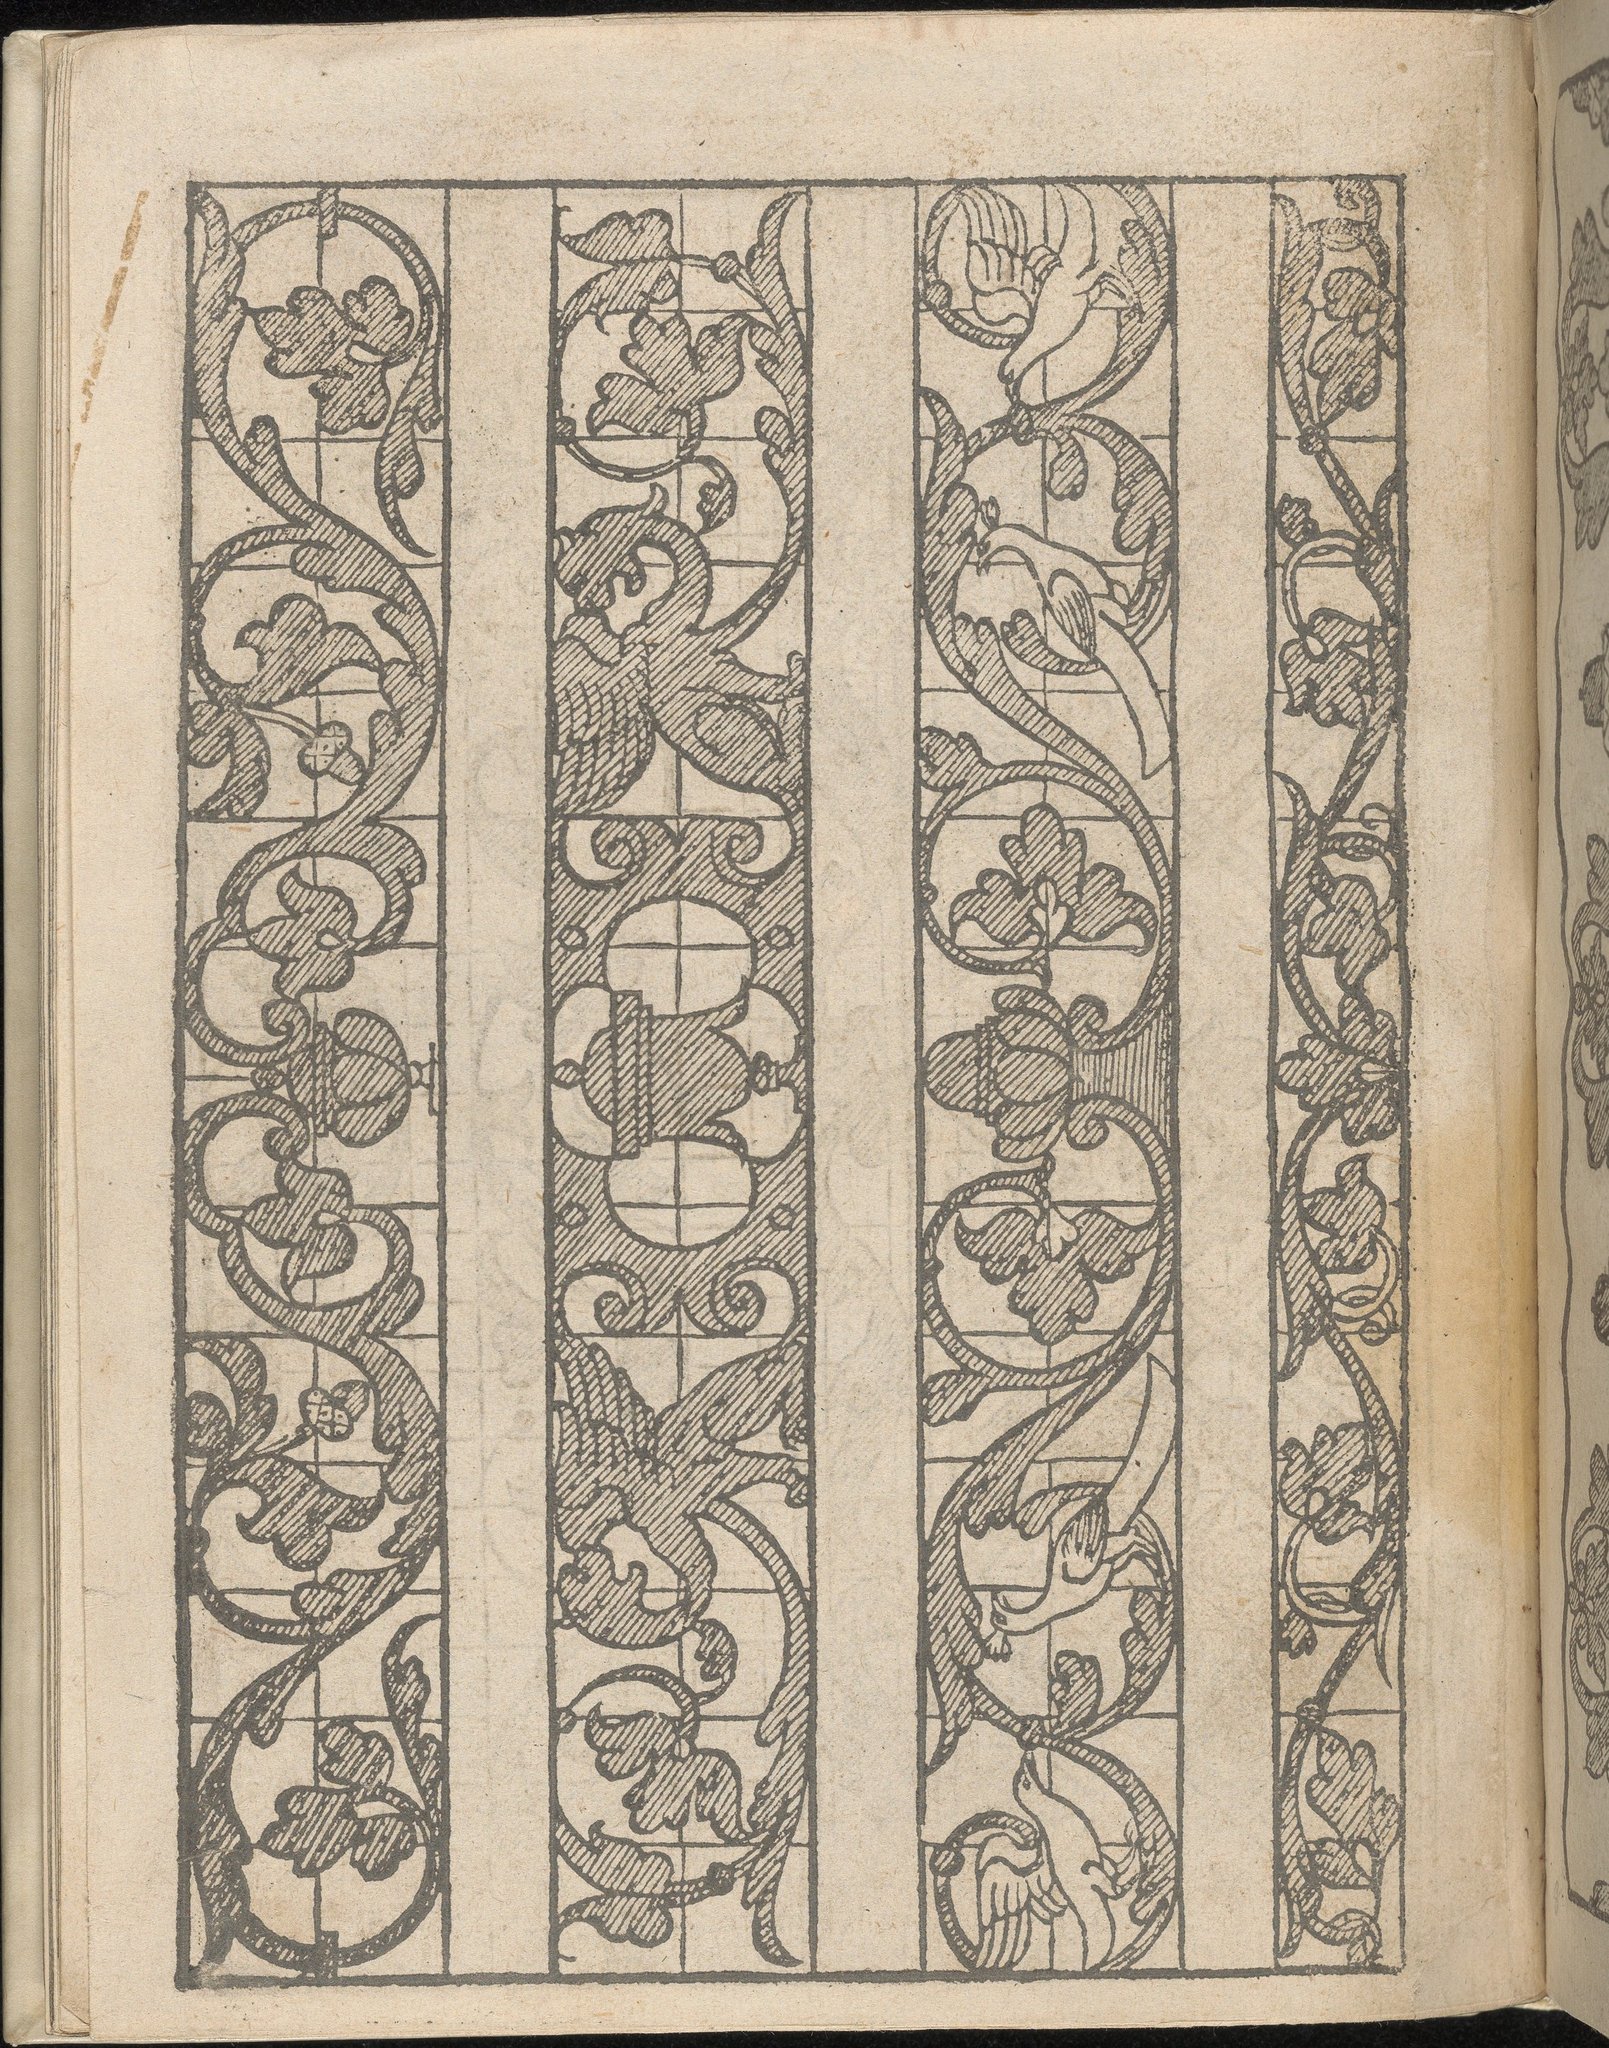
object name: book print ornament architecture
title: Lucidario di Recami, page 8 (verso)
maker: iseppo foresto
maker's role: designer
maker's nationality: italian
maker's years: 1520-1580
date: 1564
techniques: woodcut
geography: italy